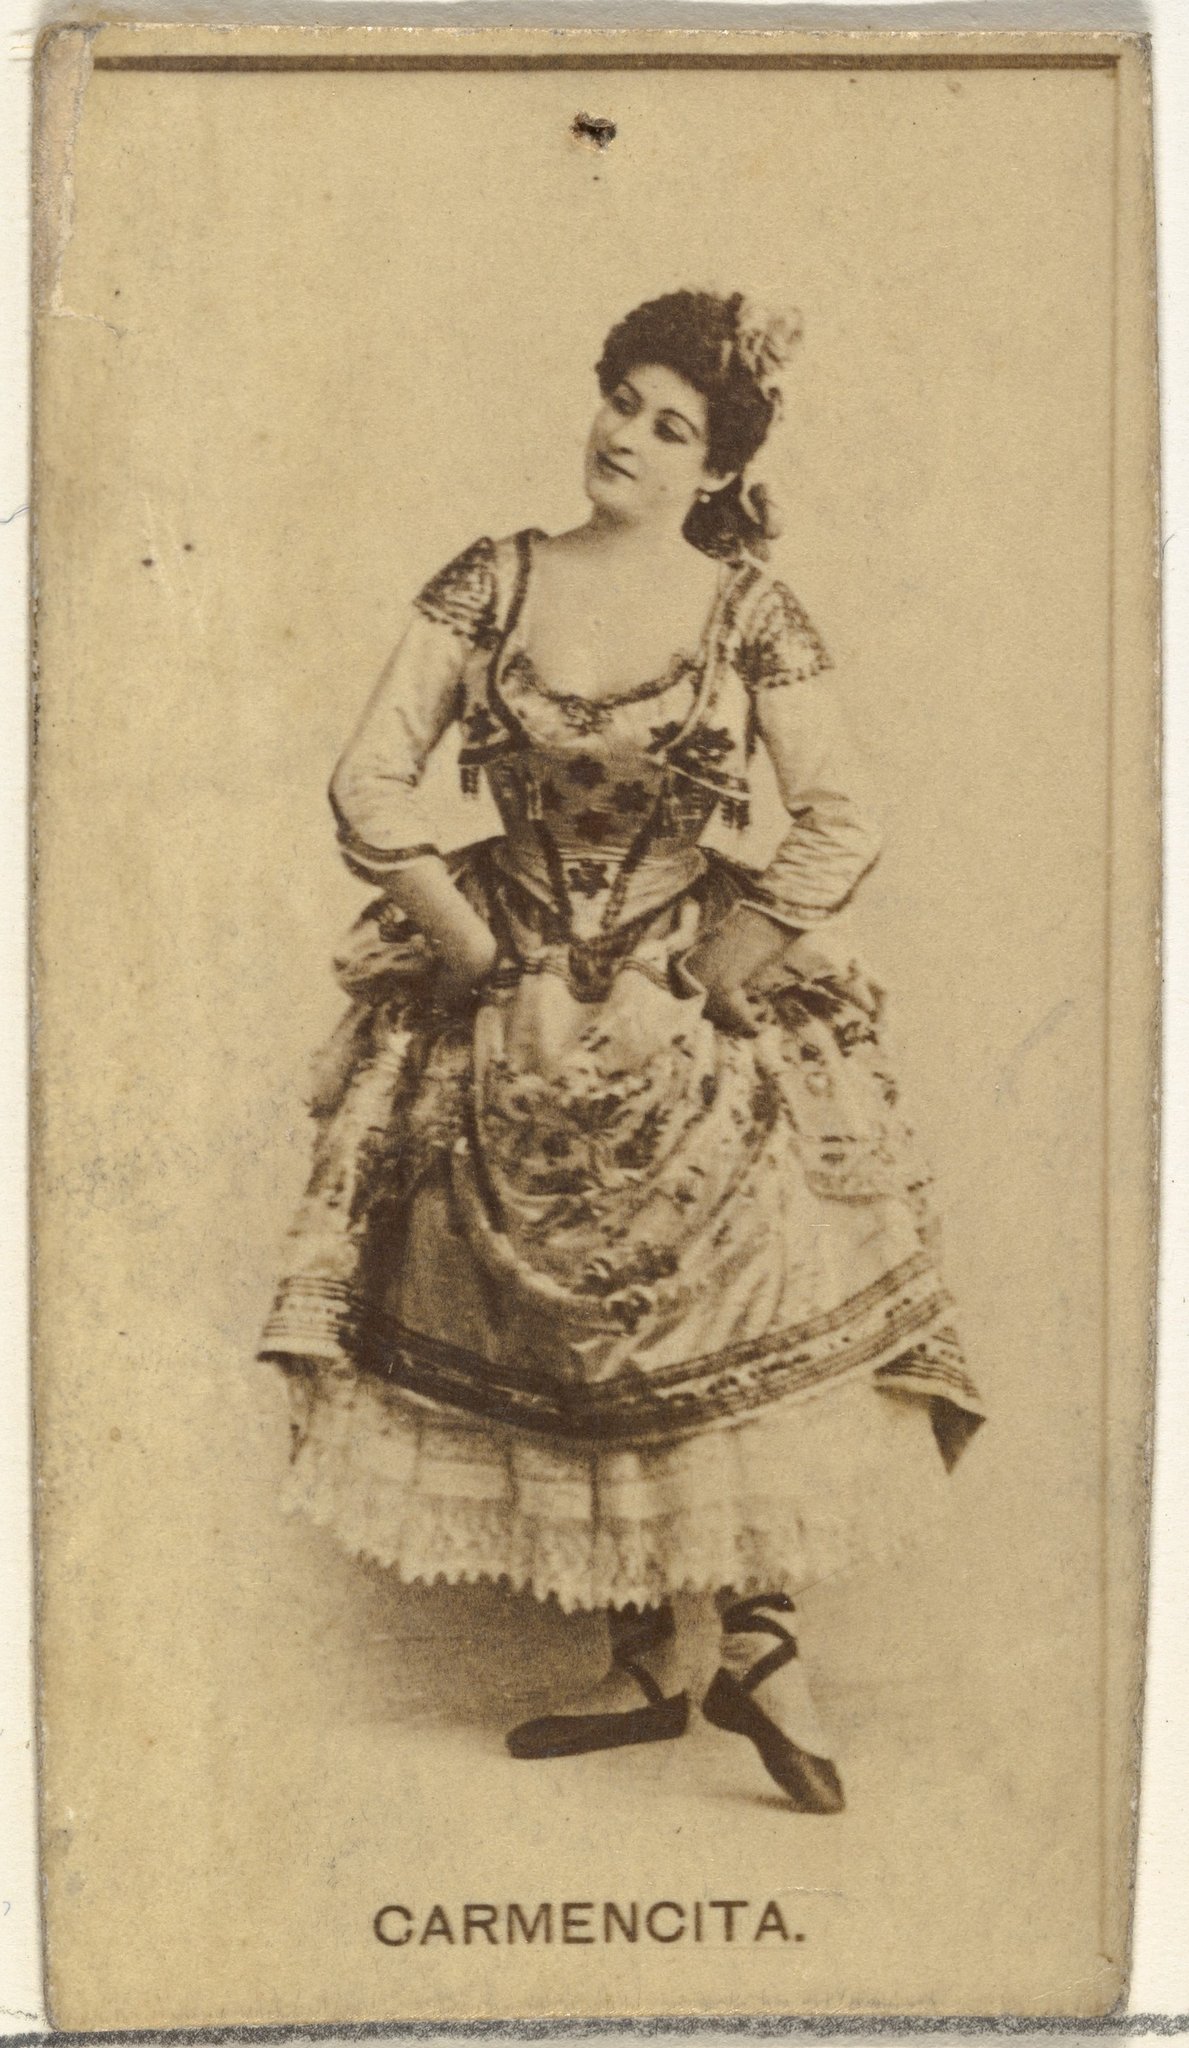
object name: photograph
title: Carmencita, from the Actors and Actresses series (N145-8) issued by Duke Sons & Co. to promote Duke Cigarettes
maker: w. duke, sons & co.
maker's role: publisher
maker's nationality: american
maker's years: 1870-1920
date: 1891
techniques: albumen silver print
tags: portraits,women,actresses